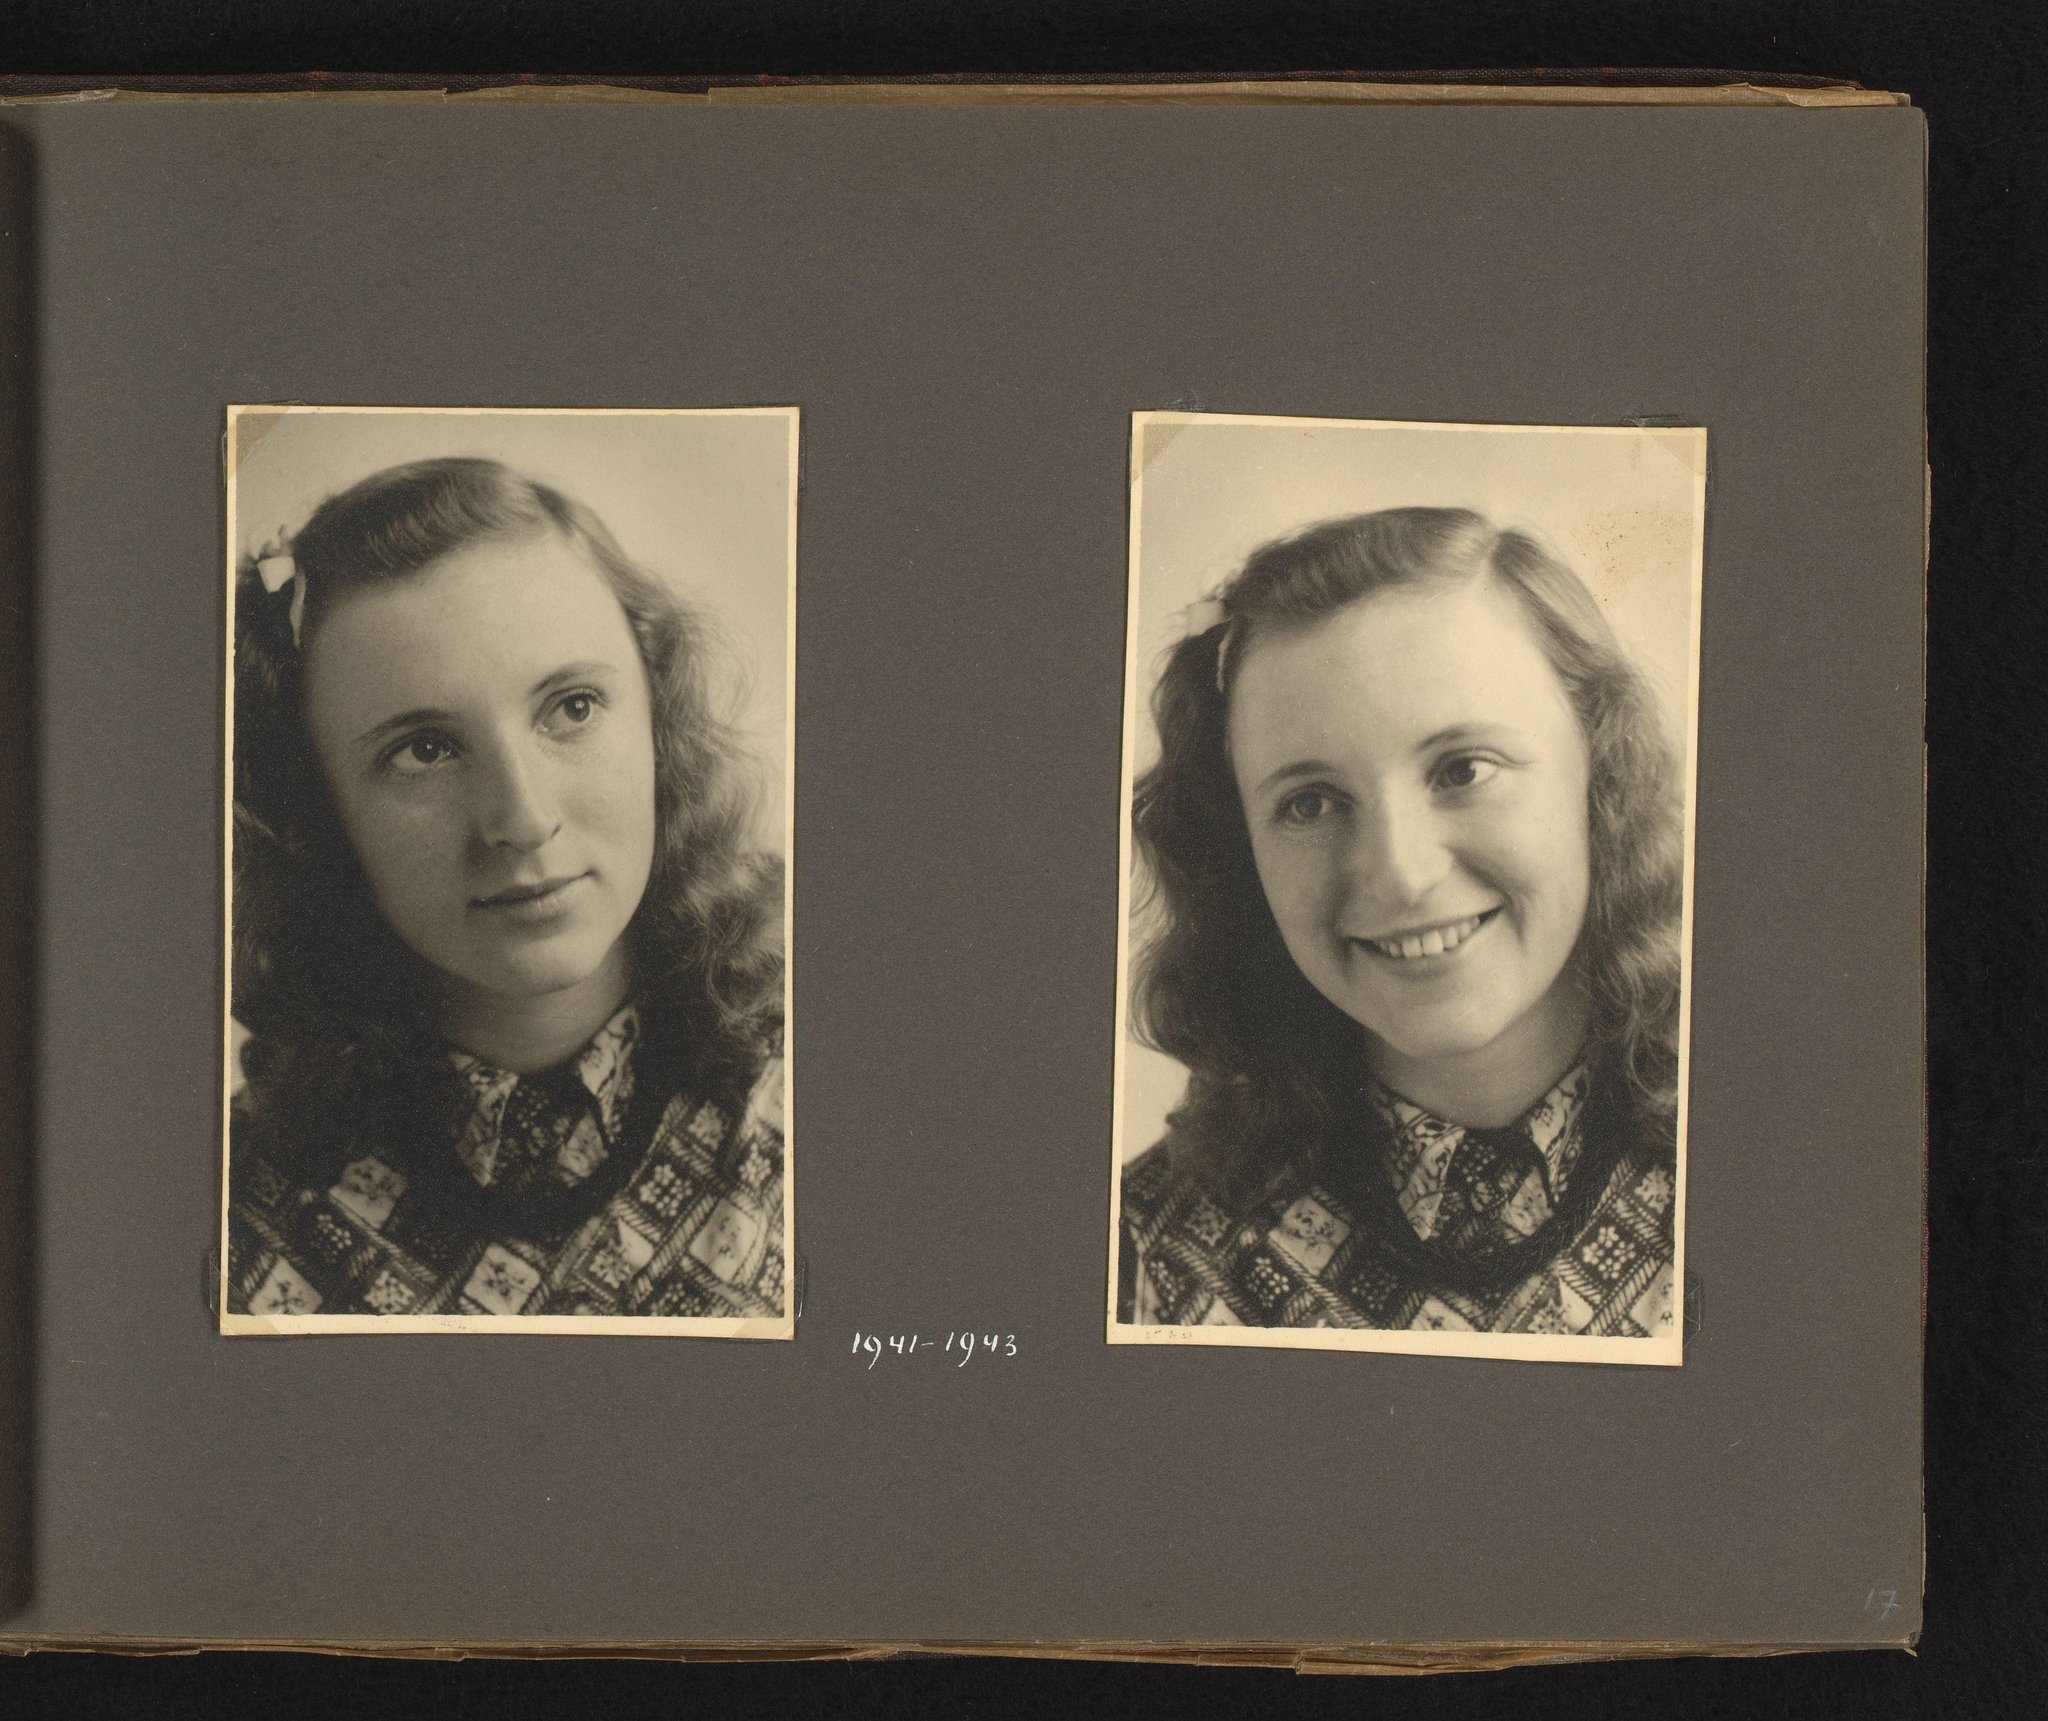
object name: album leaf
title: Portretten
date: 1941-1945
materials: paper, photographic support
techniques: gelatin silver print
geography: the hague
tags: historical persons - bb - woman, netherlands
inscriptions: inscription: ‘1941-1943’, inscription: ‘1945’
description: Albumblad met twee foto's met portretten van de samensteller van het album, 1941-1943 of 1945. Onderdeel van het Familiealbum 1940-1947